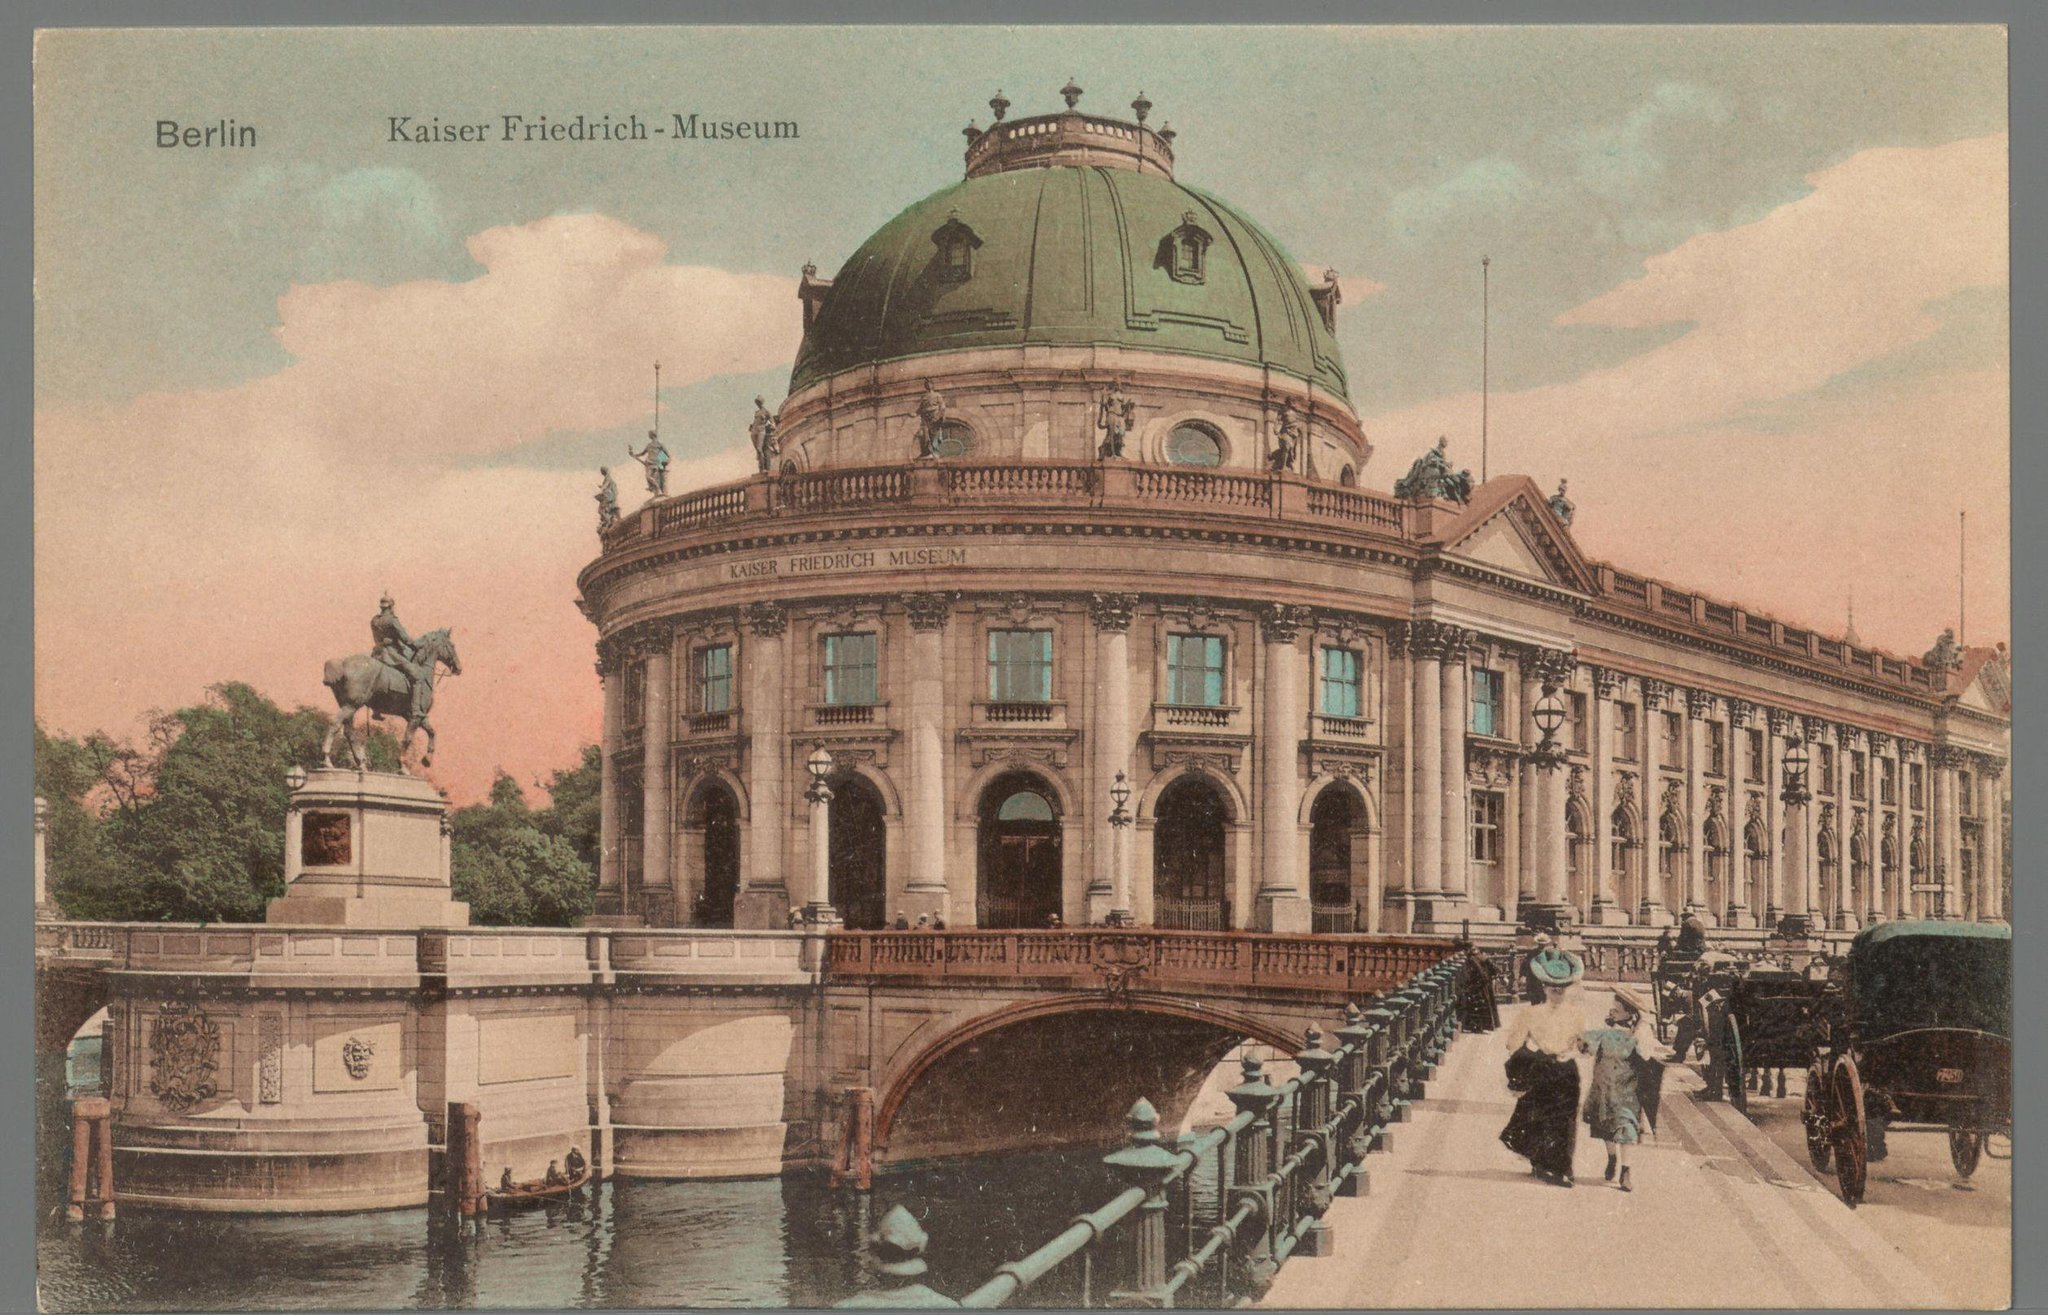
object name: photomechanical print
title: Berlin. Kaiser Friedrich-Museum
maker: Anonymous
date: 1905-1930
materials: cardboard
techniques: photograph, lithograph, hand coloring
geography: berlin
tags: monument, statue, permanent exhibition, museum